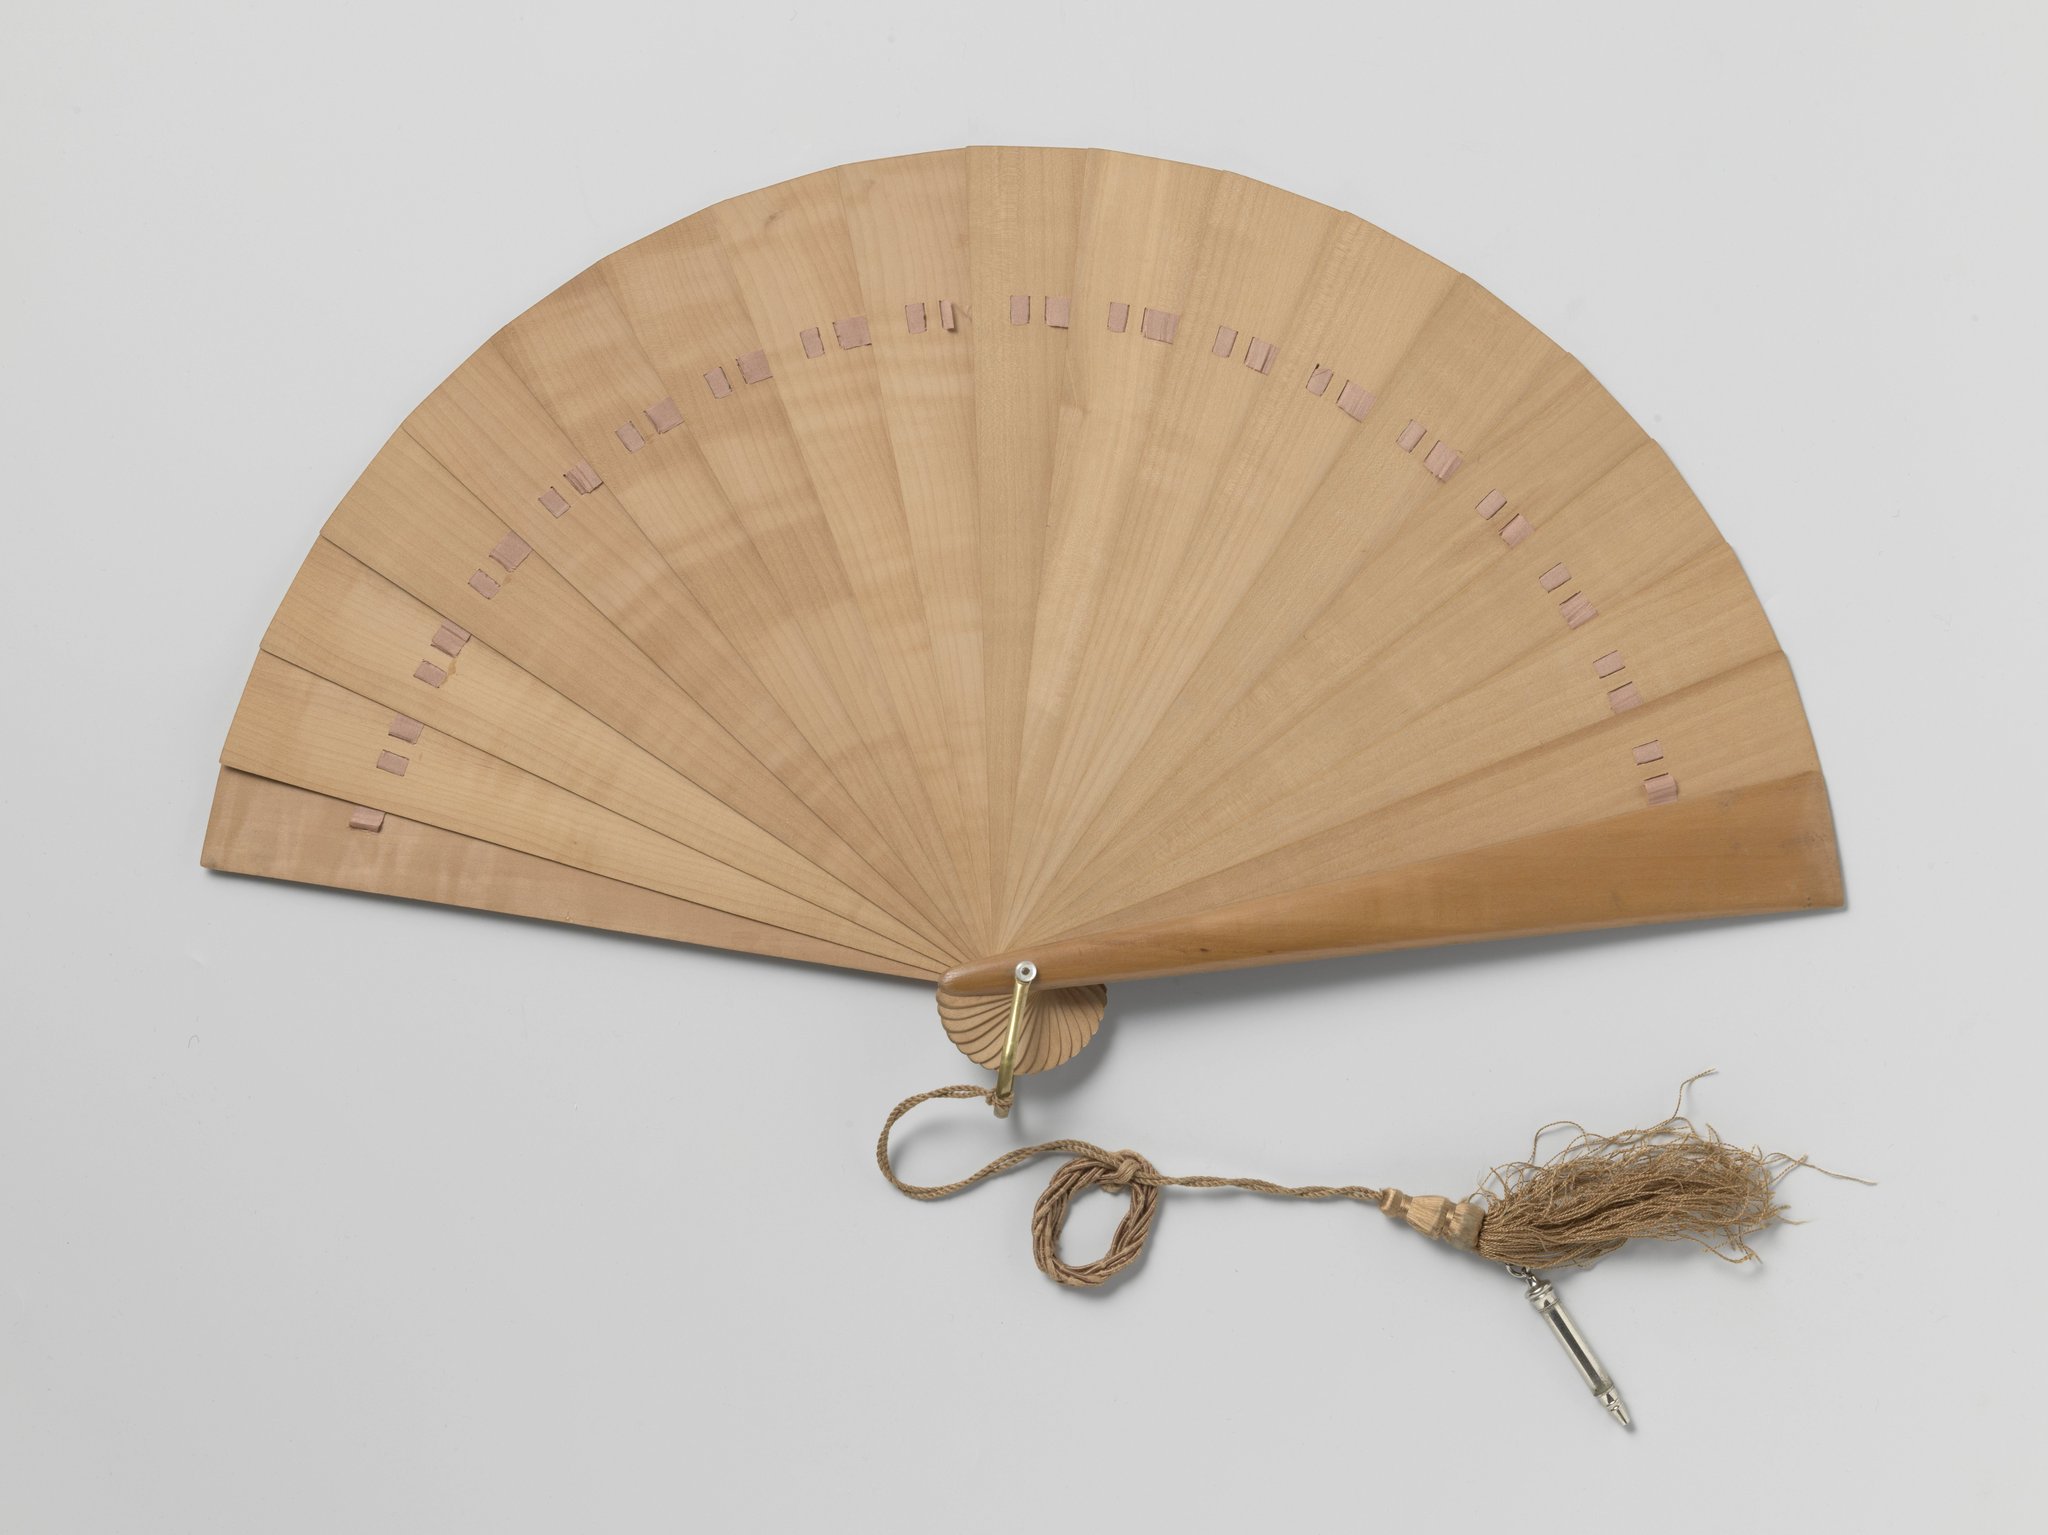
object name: brisé fan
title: Brisé waaier, te gebruiken als balboekje, van hout met koperen waaierring waaraan een zijden koord met potlood in nikkelen houder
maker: Anonymous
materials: copper, mother of pearl, nickel, silk, wood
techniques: cutting, weave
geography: netherlands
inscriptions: name: ‘Eulenburg’, name: ‘Welsersheimb’, date: ‘16.I.1901 of 1907’, name: ‘Van der Hoeven’, date: ‘20.1.1901 of 1907’, name: ‘cotillon’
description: Brisé waaier, te gebruiken als balboekje, van hout met koperen waaierring waaraan een zijden koord met potlood in nikkelen houder. Model: bestaand uit 17 benen van blank hout en twee sluitbenen van gelakt hout. Waaierlint in dezelfde roze-beige kleur als de benen. Sluitring van parelmoer. Gedraaid zijden koord met kwast en ring om waaier tijdens het dansen aan een van de vingers te dragen. Kwast met kern van hout waar zijden draad omheen is gespannen en eindigend in een bos getwijnde zijden draden. Nikkelen houder waar met een draaiende beweging het potlood uit te voorschijn komt. Aan de achterzijde inscripties en handtekeningen gezet.